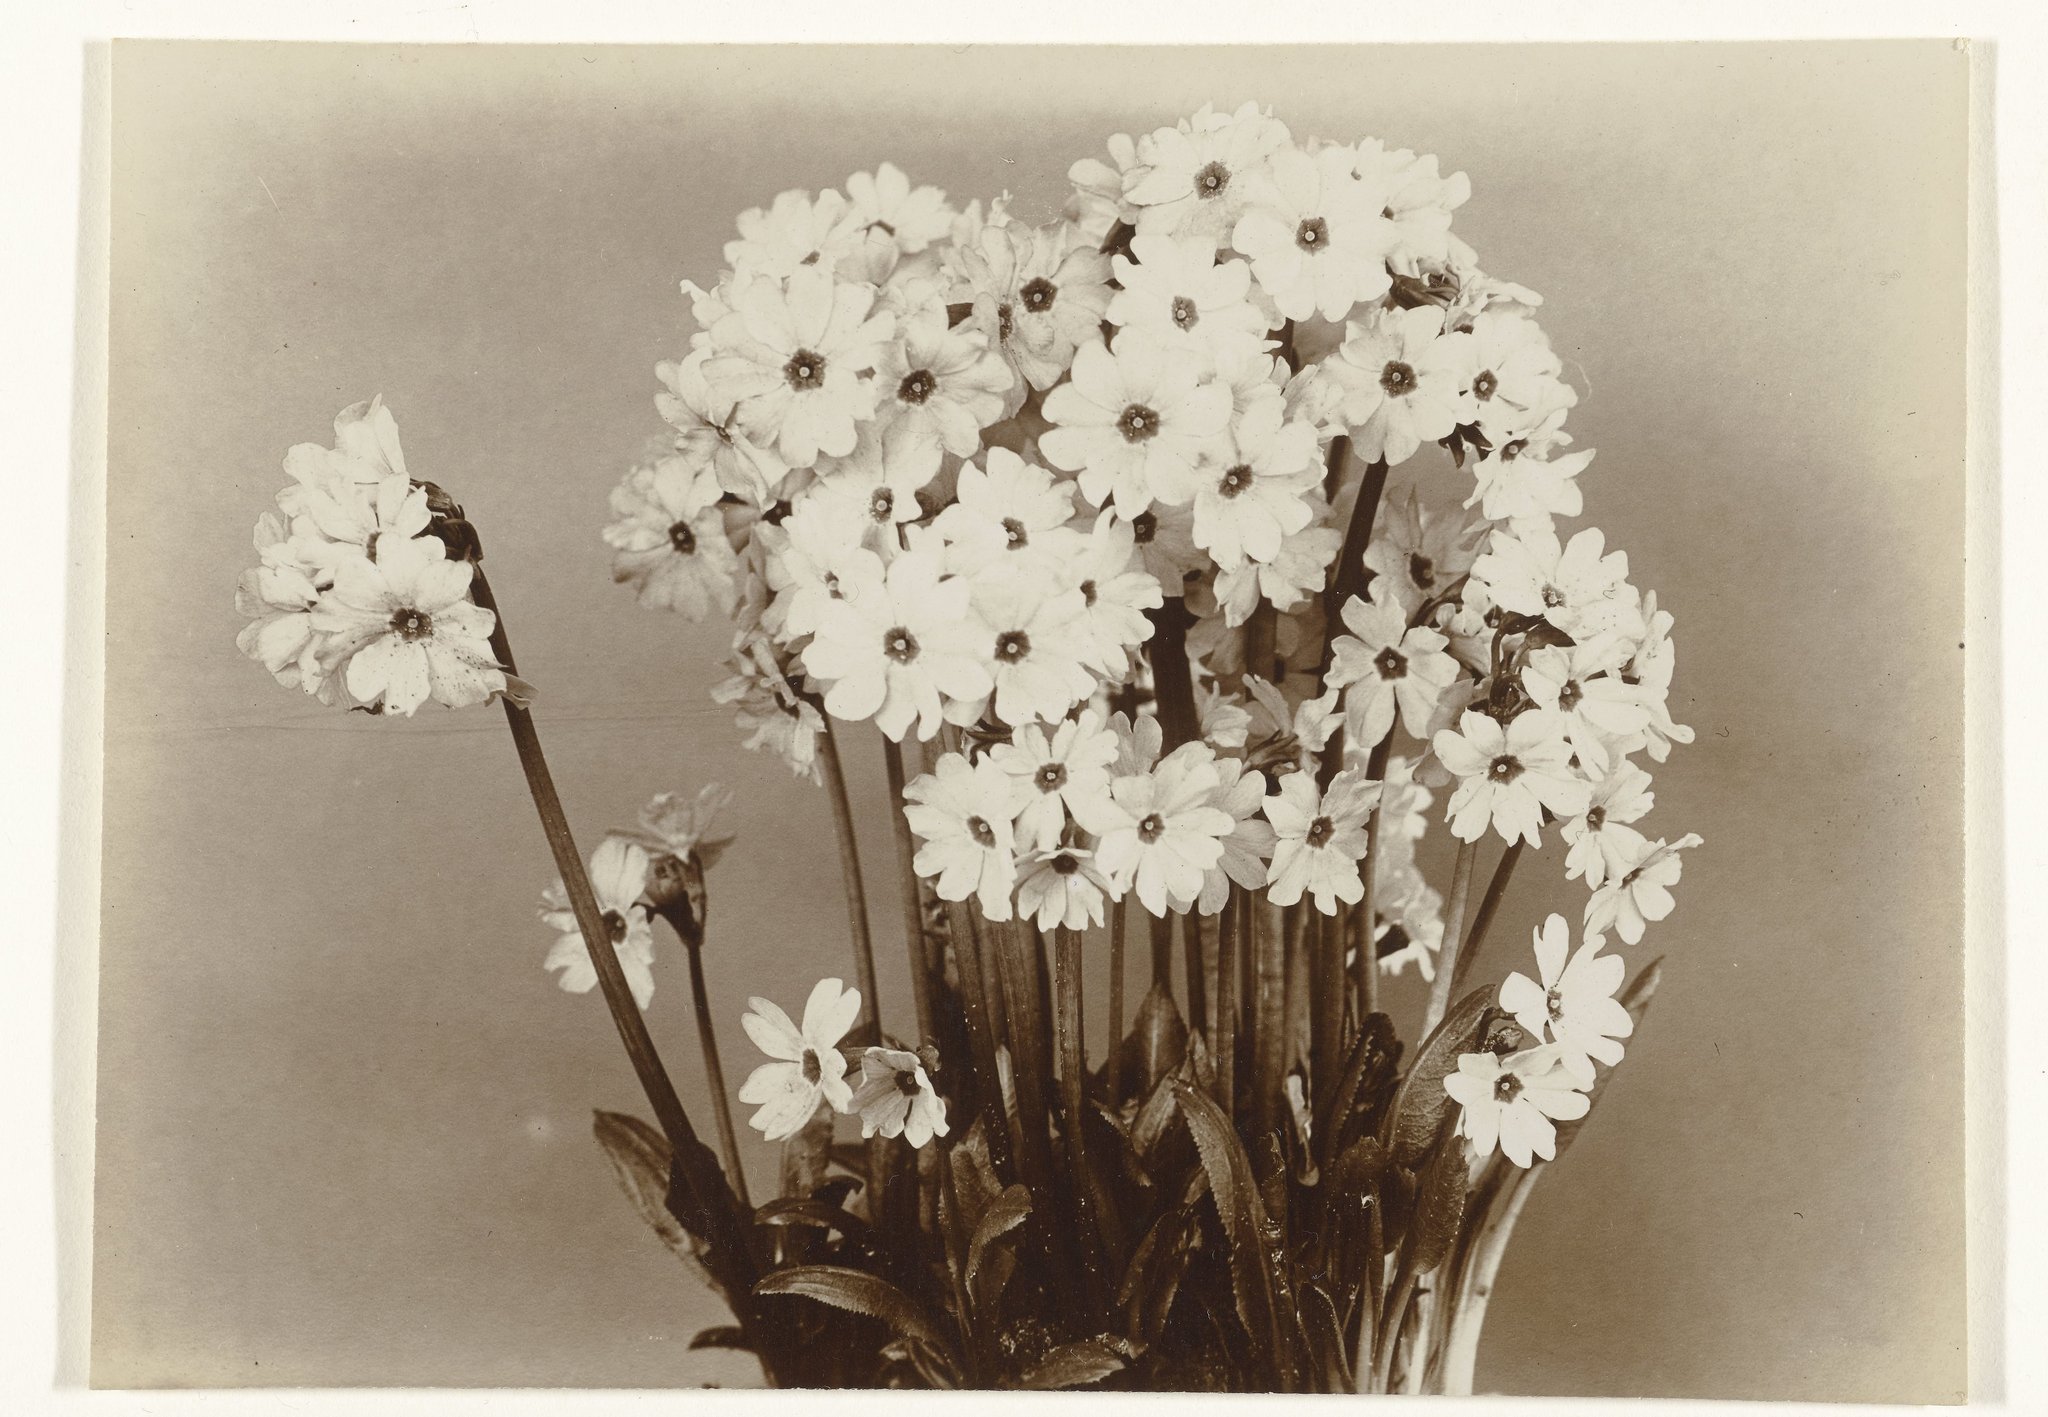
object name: photograph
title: Primula rosea of sleutelbloem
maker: richard tepe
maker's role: fotograaf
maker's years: 1864-1952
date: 1900-1930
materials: photographic support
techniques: gelatin silver print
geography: netherlands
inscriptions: signature: ‘foto / R. Tepe’, annotation: ‘Primula rosea grandiflora / [onleesbaar]’